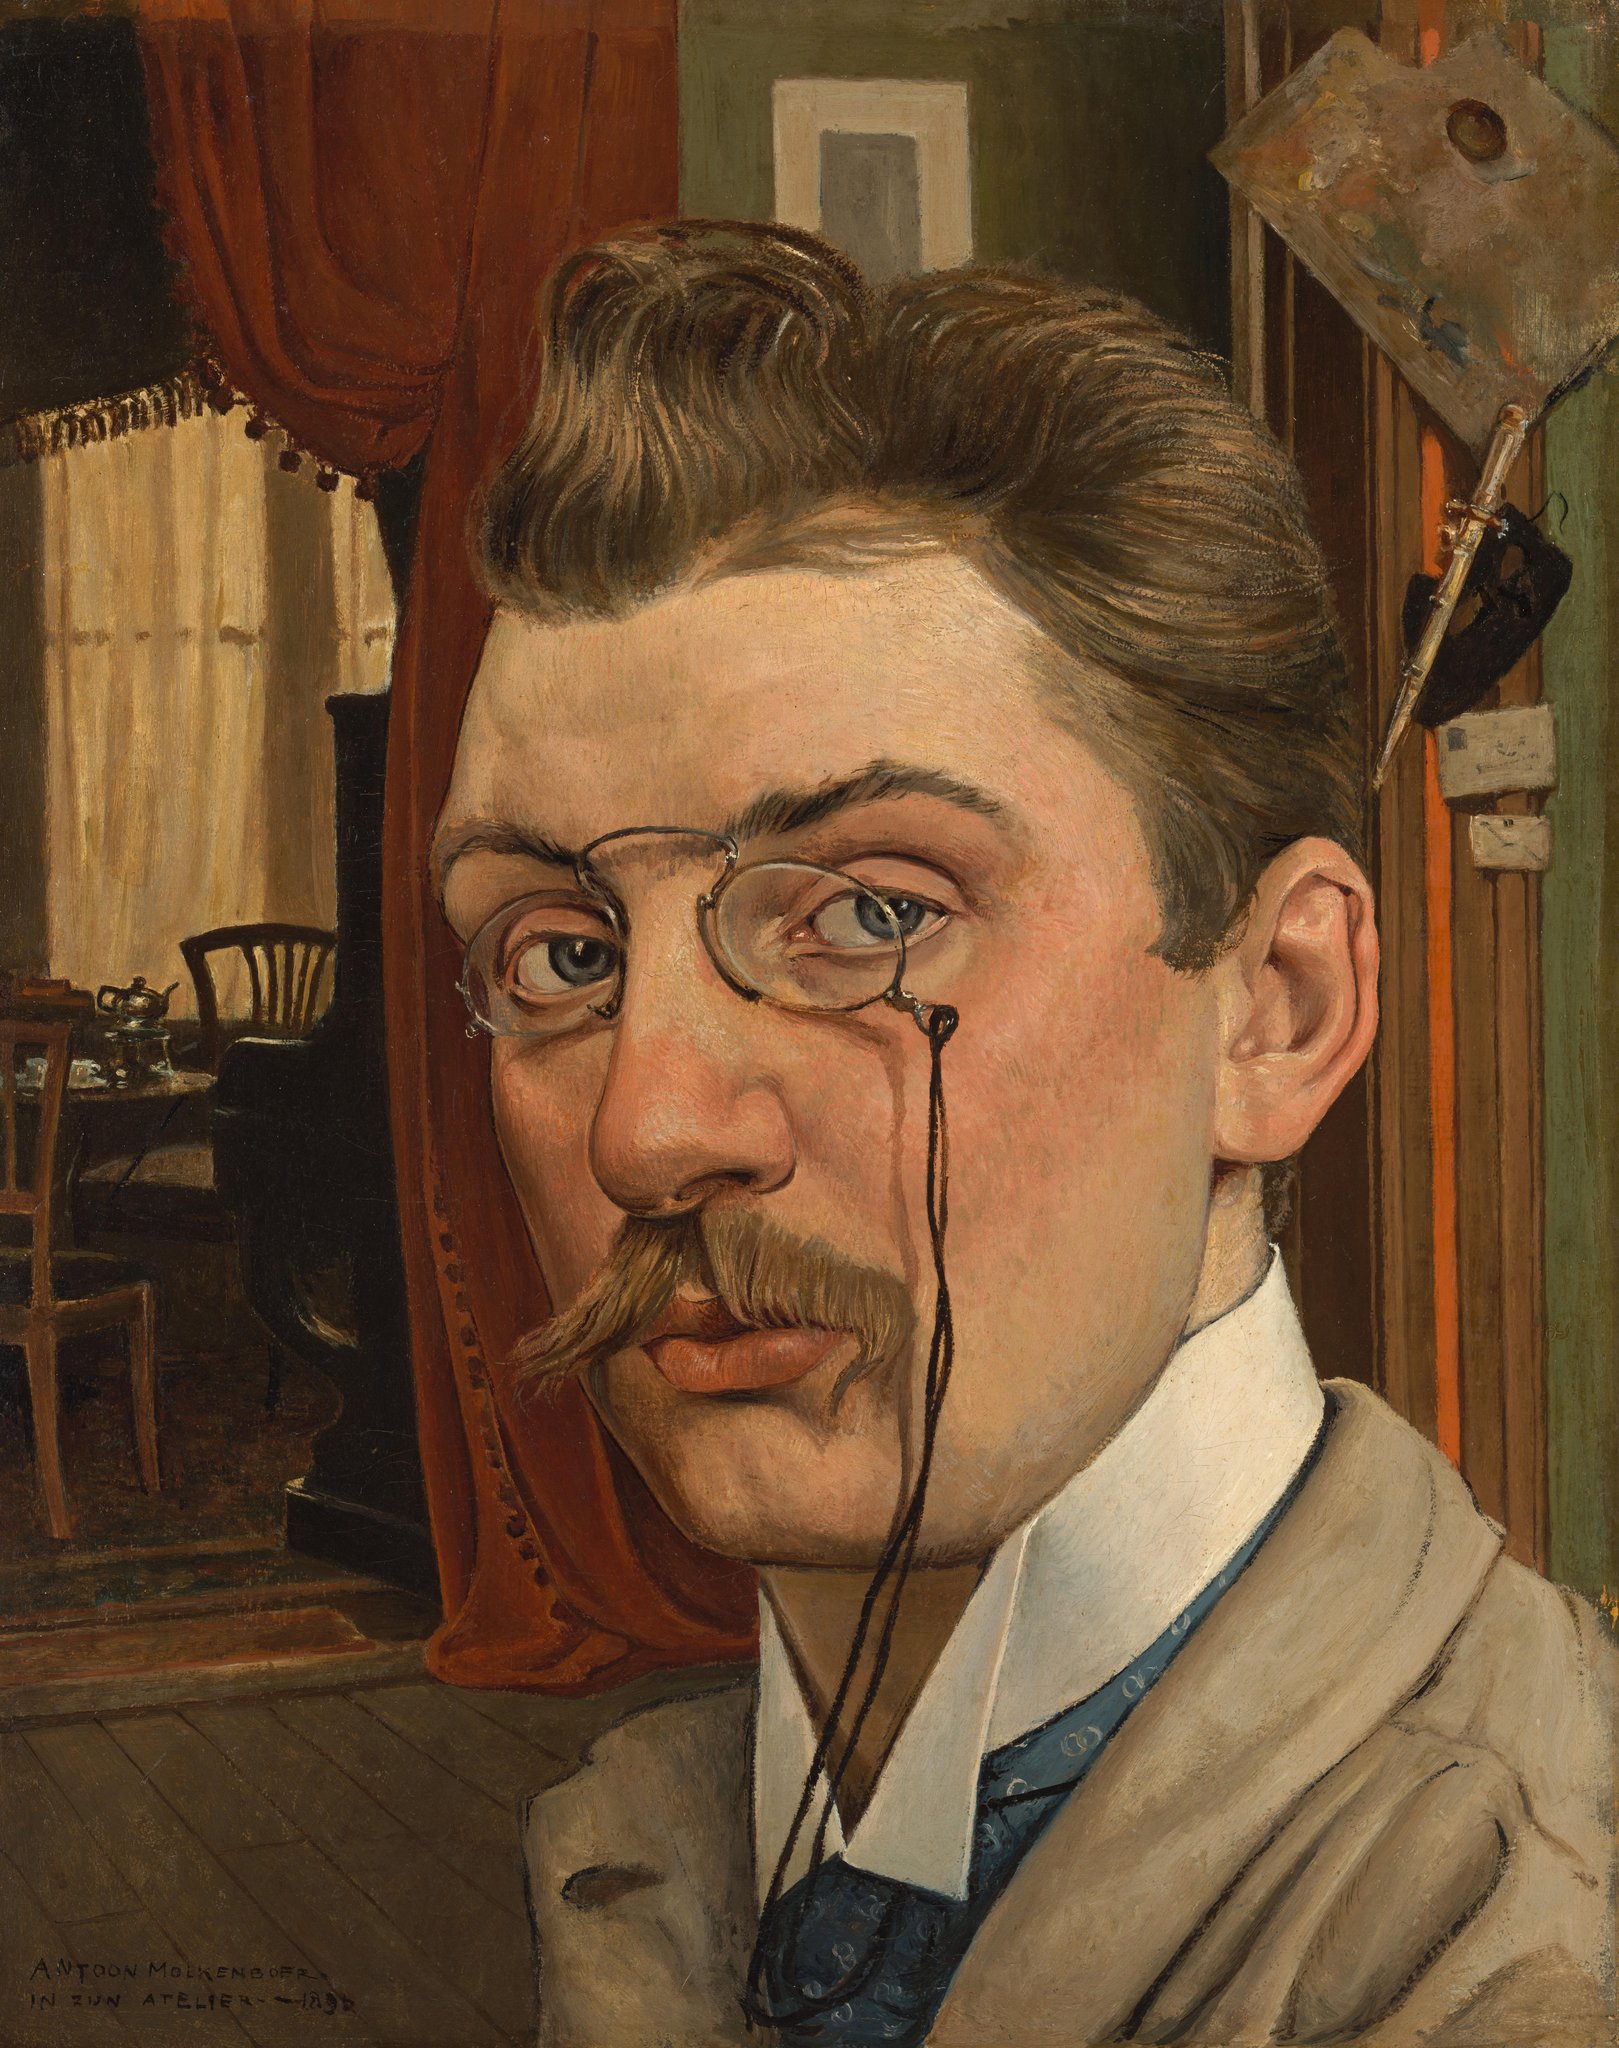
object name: painting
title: Self-portrait in his Studio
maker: anton molkenboer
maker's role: print maker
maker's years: 1872-1960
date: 1896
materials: canvas, oil, paint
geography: amsterdam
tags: haarlem, print maker, anton molkenboer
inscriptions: inscription: ‘Antoon Molkenboer / in zijn atelier — 1896’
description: The young painter Molkenboer scrutinizes himself through his pince-nez. He is in his Amsterdam studio, with the dining room behind him. A palette and stage mask hang from a cupboard or doorpost on the right. The year 1896 was important for Molkenboer. Although trained as a painter, he had just written and produced his first play. He would eventually unite both passions and work for the theatre as a decorative artist.